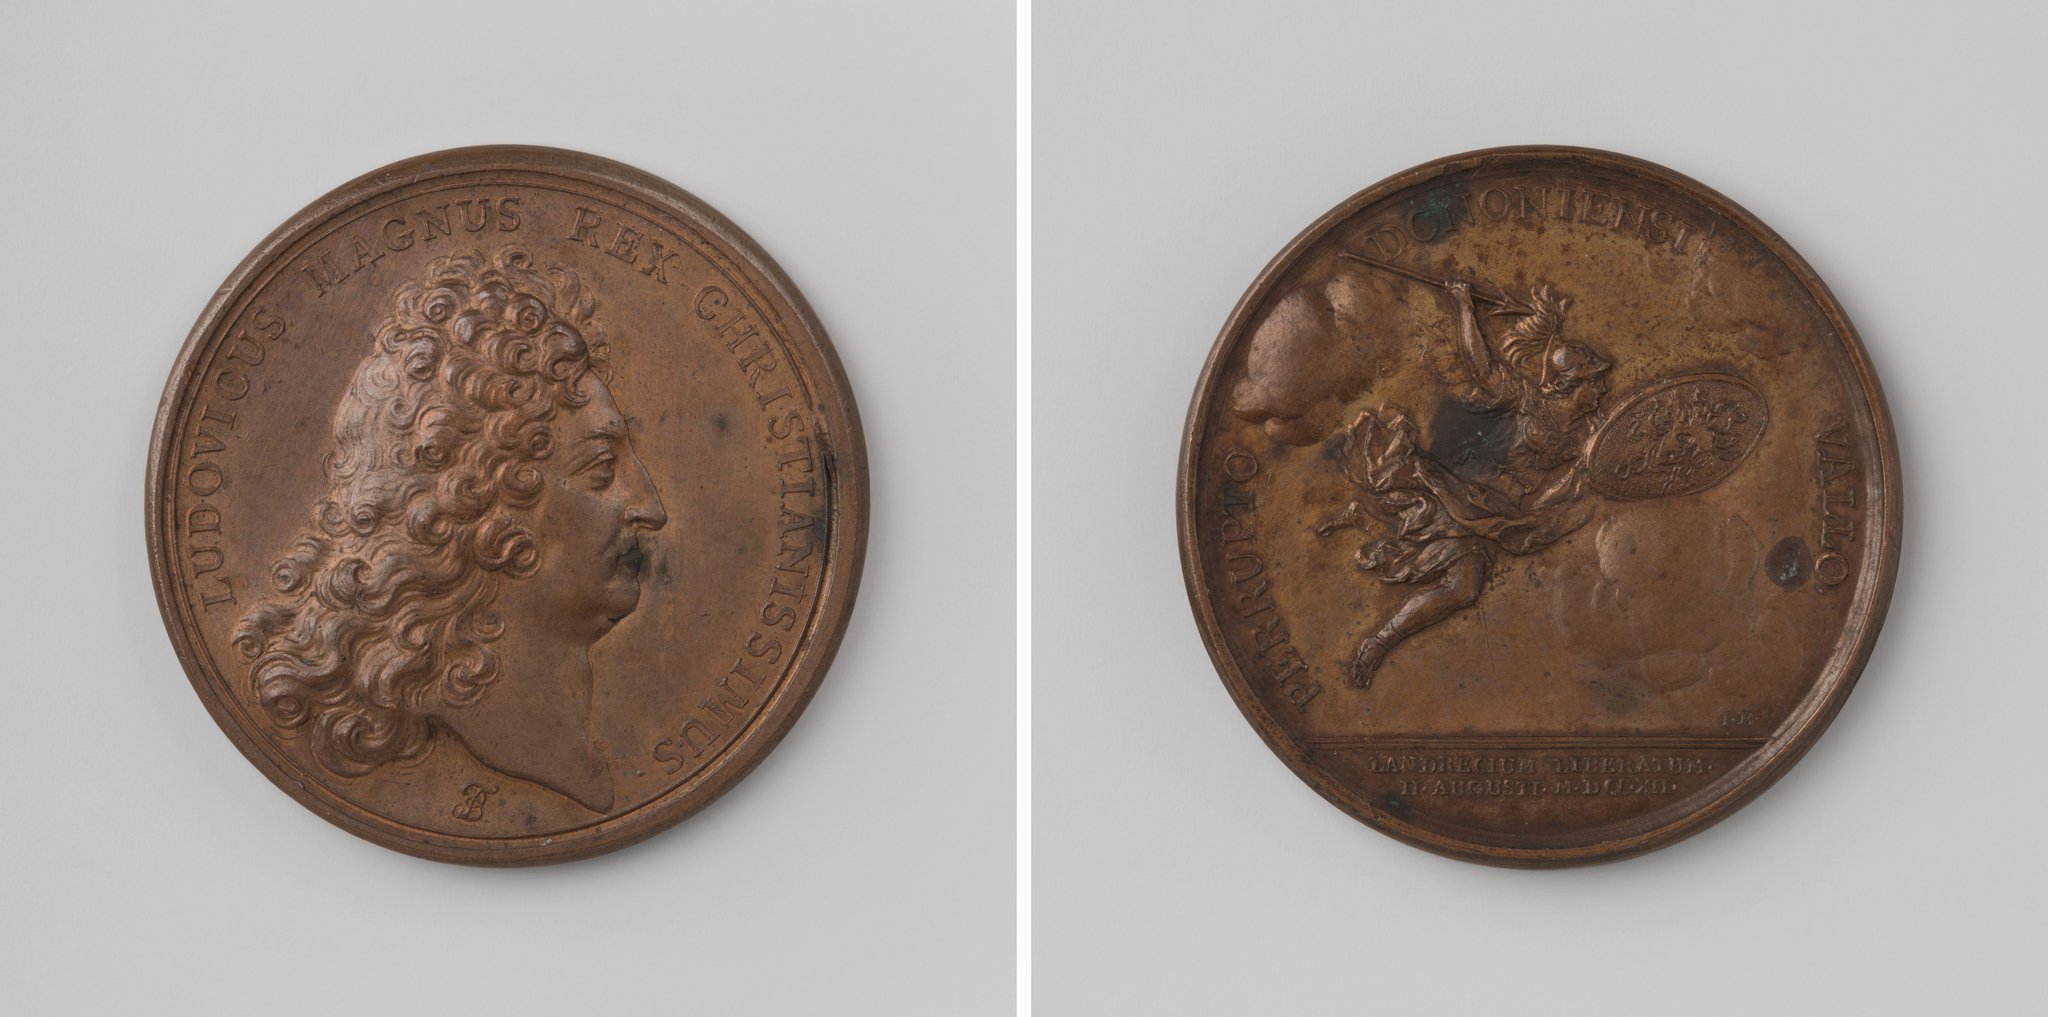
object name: history medal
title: Verovering van de schansen bij Denain en ontzet van Landrecy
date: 1712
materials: bronze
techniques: striking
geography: paris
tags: lodewijk xiv (koning van frankrijk)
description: Bronzen penning. Voorzijde: borststuk man binnen omschrift. Keerzijde: Pallas vliegend met speer en schild in aanslag binnen omschrift; afsnede: opschrift